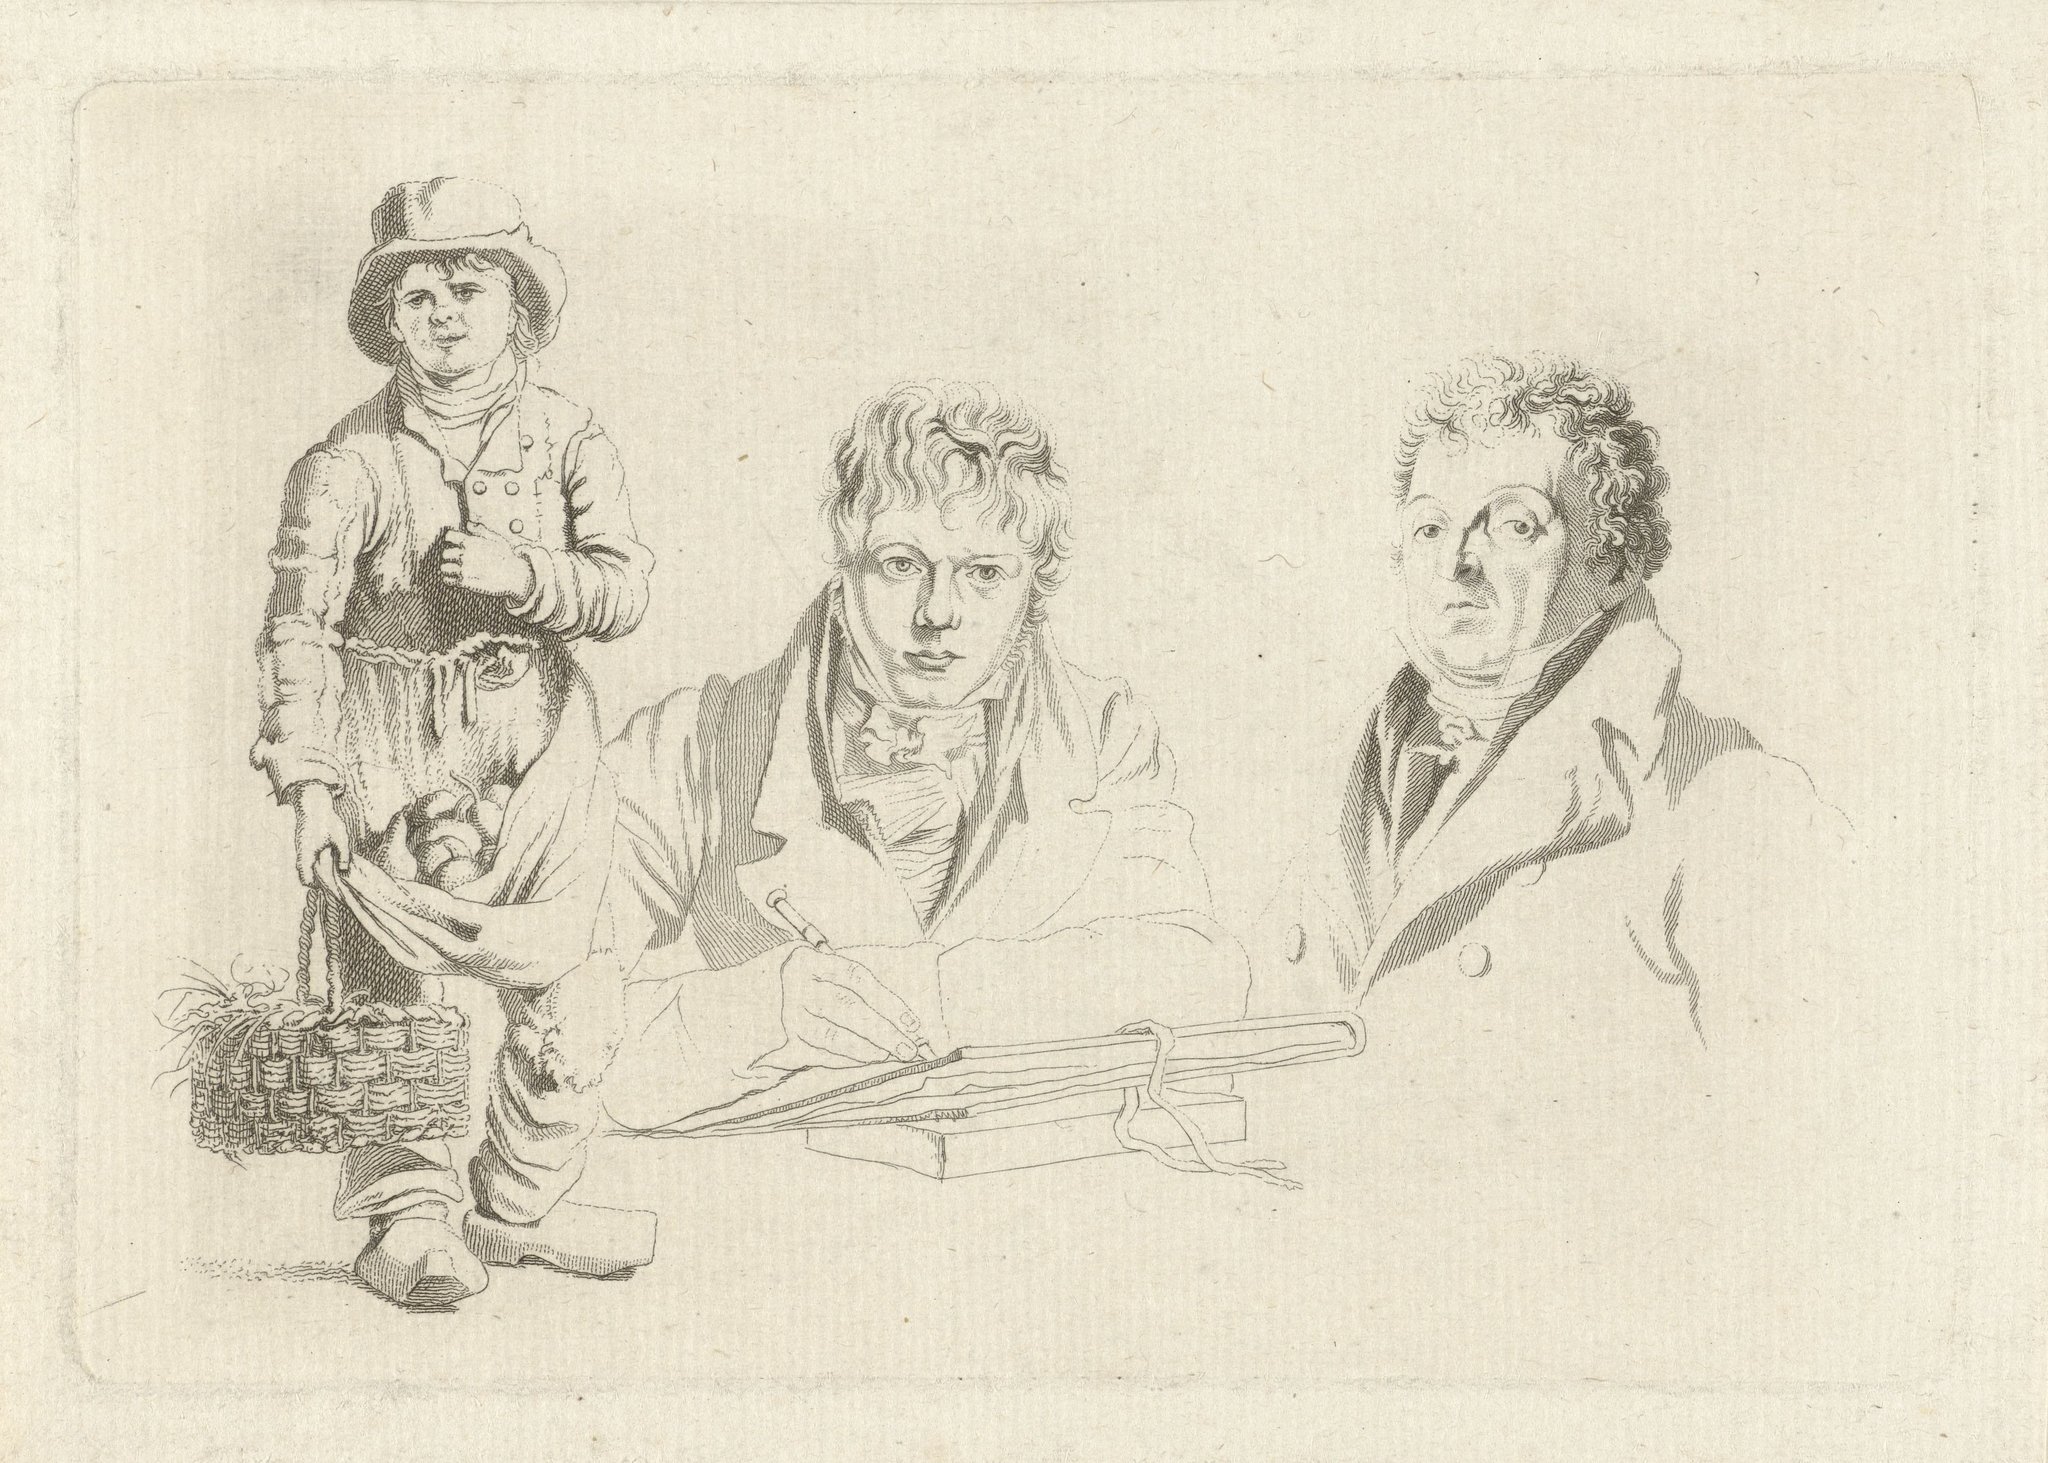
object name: print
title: Portretten van J.P. Visser Bender en P.Pz. Barbiers naast een jongen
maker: jacob ernst marcus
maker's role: draughtsman, print maker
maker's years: 1774-1826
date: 1812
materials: paper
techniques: etching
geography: amsterdam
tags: pieter pietersz. barbiers, joannes pieter visser bender, painting, drawing and the graphic arts (+ artist at work), container made of plant material other than wood: basket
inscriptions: collector's mark: Lugt 2228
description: Portretten van de kunstenaars Joannes Pieter Visser Bender en Pieter Pietersz. Barbiers naast een arm geklede jongen met een mand in zijn hand en fruit in zijn schort.